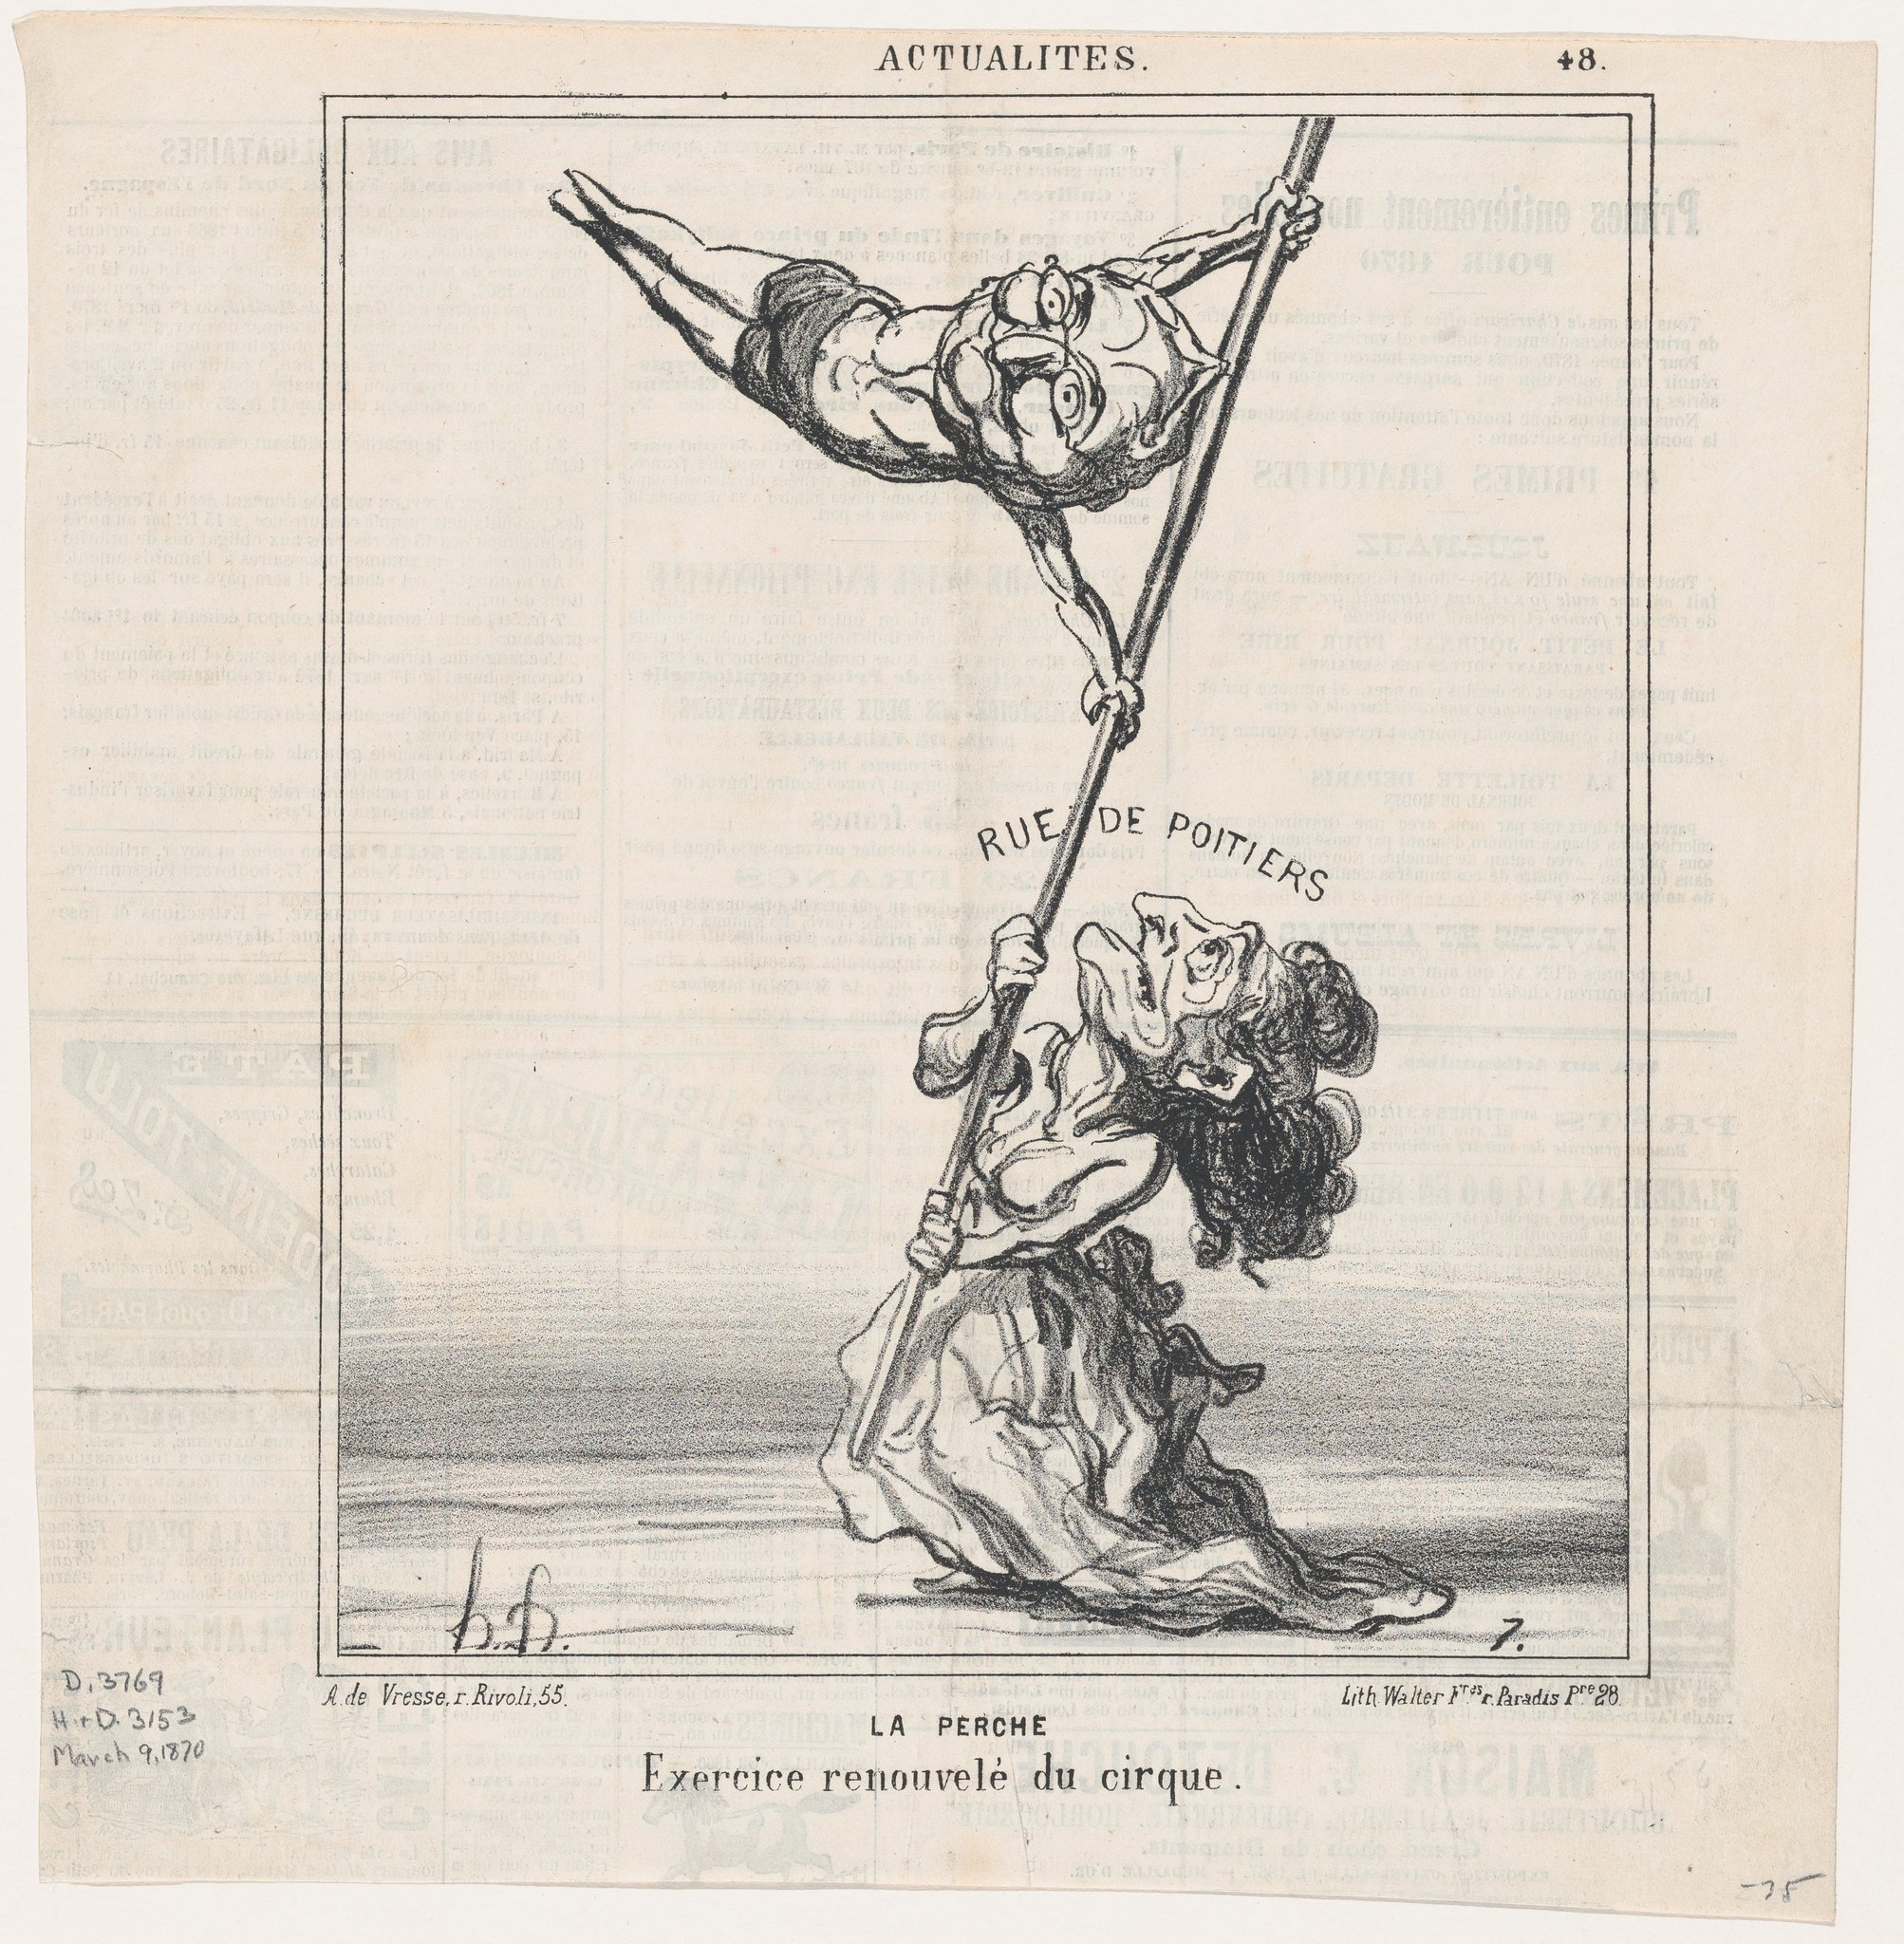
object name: print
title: Pole-vault: An exercise taken from the circus, from 'News of the day,' published in Le Charivari, March 9, 1870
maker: honoré daumier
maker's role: artist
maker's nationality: french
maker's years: 1808-1879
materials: paper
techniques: lithograph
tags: satire,men,women